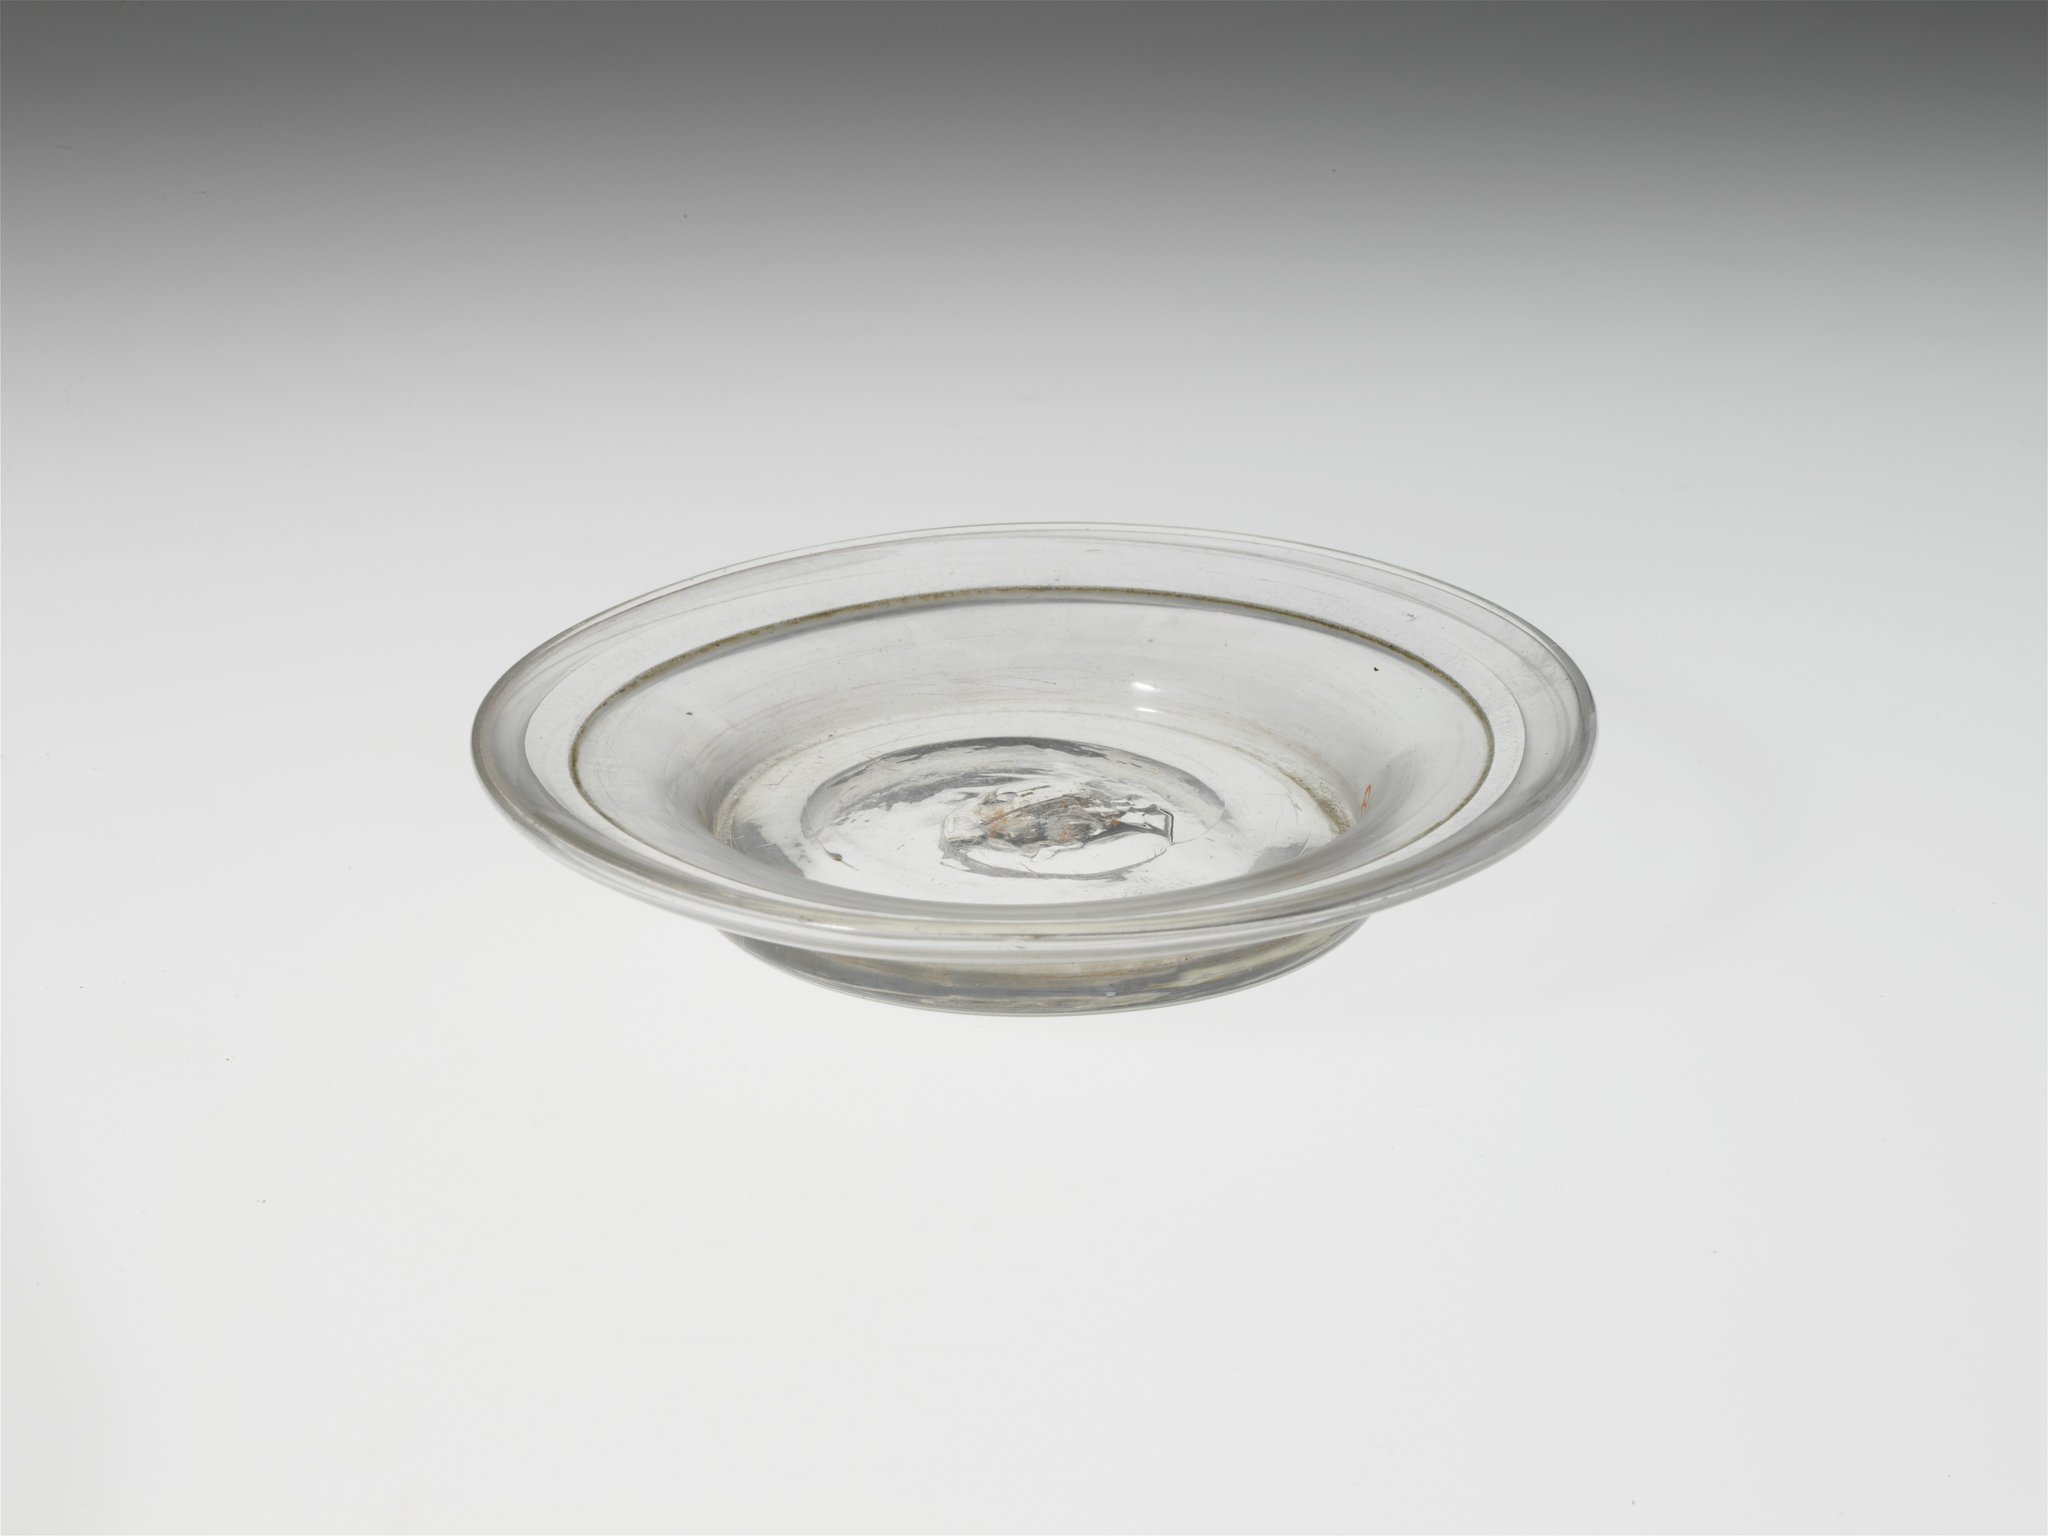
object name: cup plate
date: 1825-1860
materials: glass